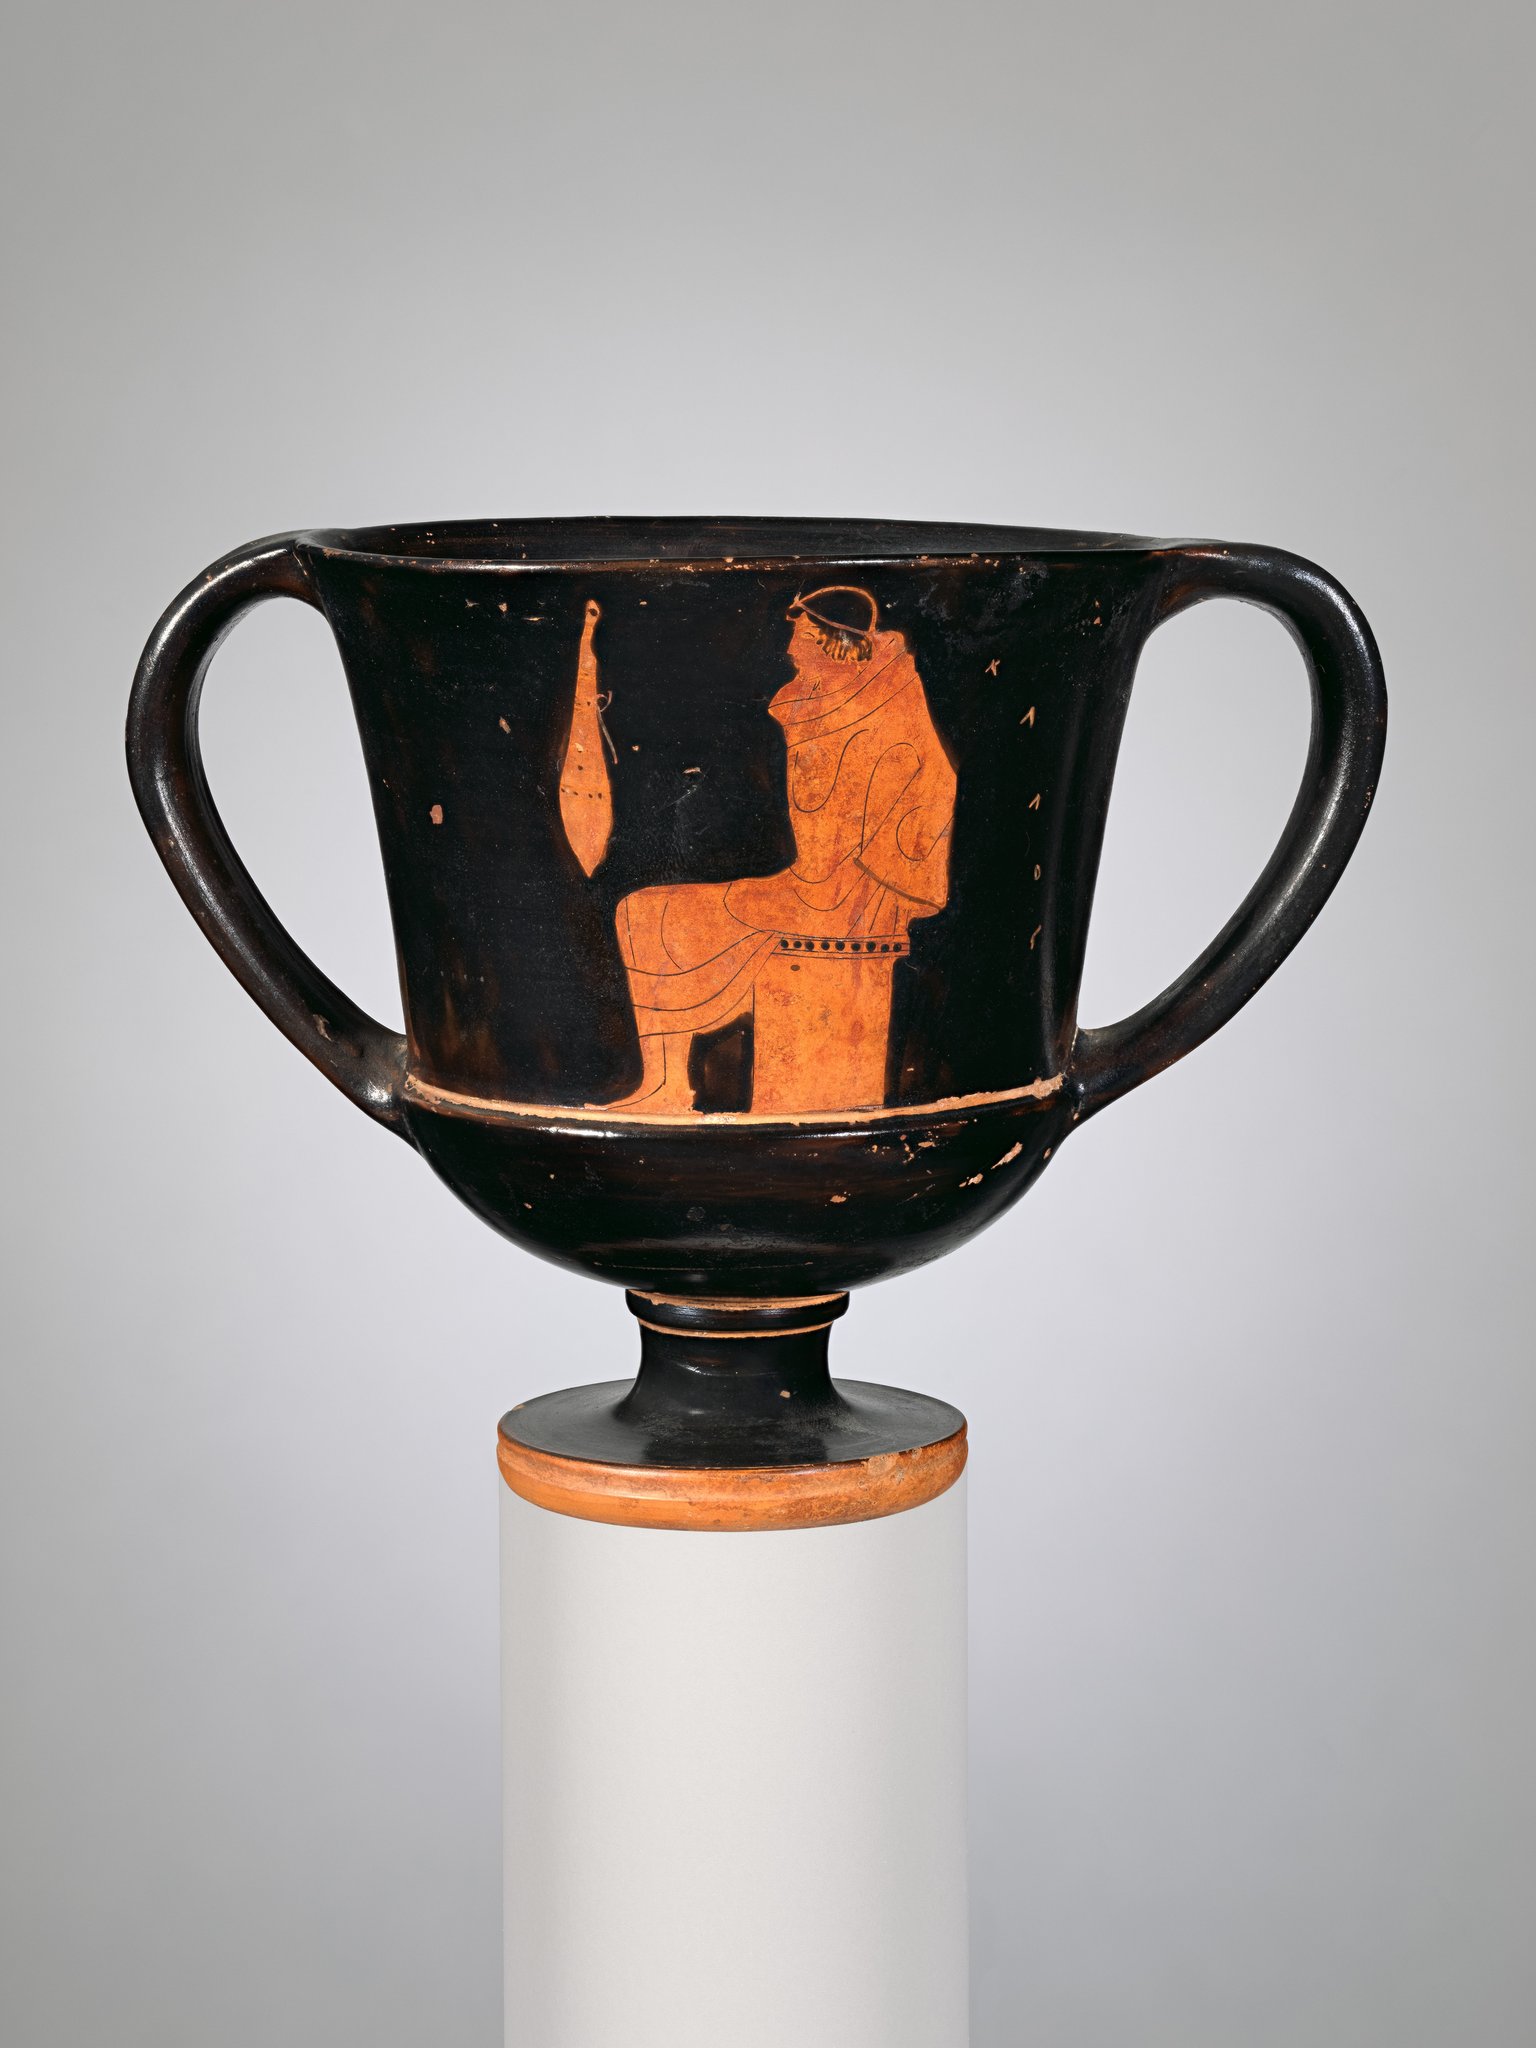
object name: kantharos, type b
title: Terracotta kantharos (drinking cup with vertical handles)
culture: greek, attic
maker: painter of athens 10464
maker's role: artist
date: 450-425 BCE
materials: terracotta